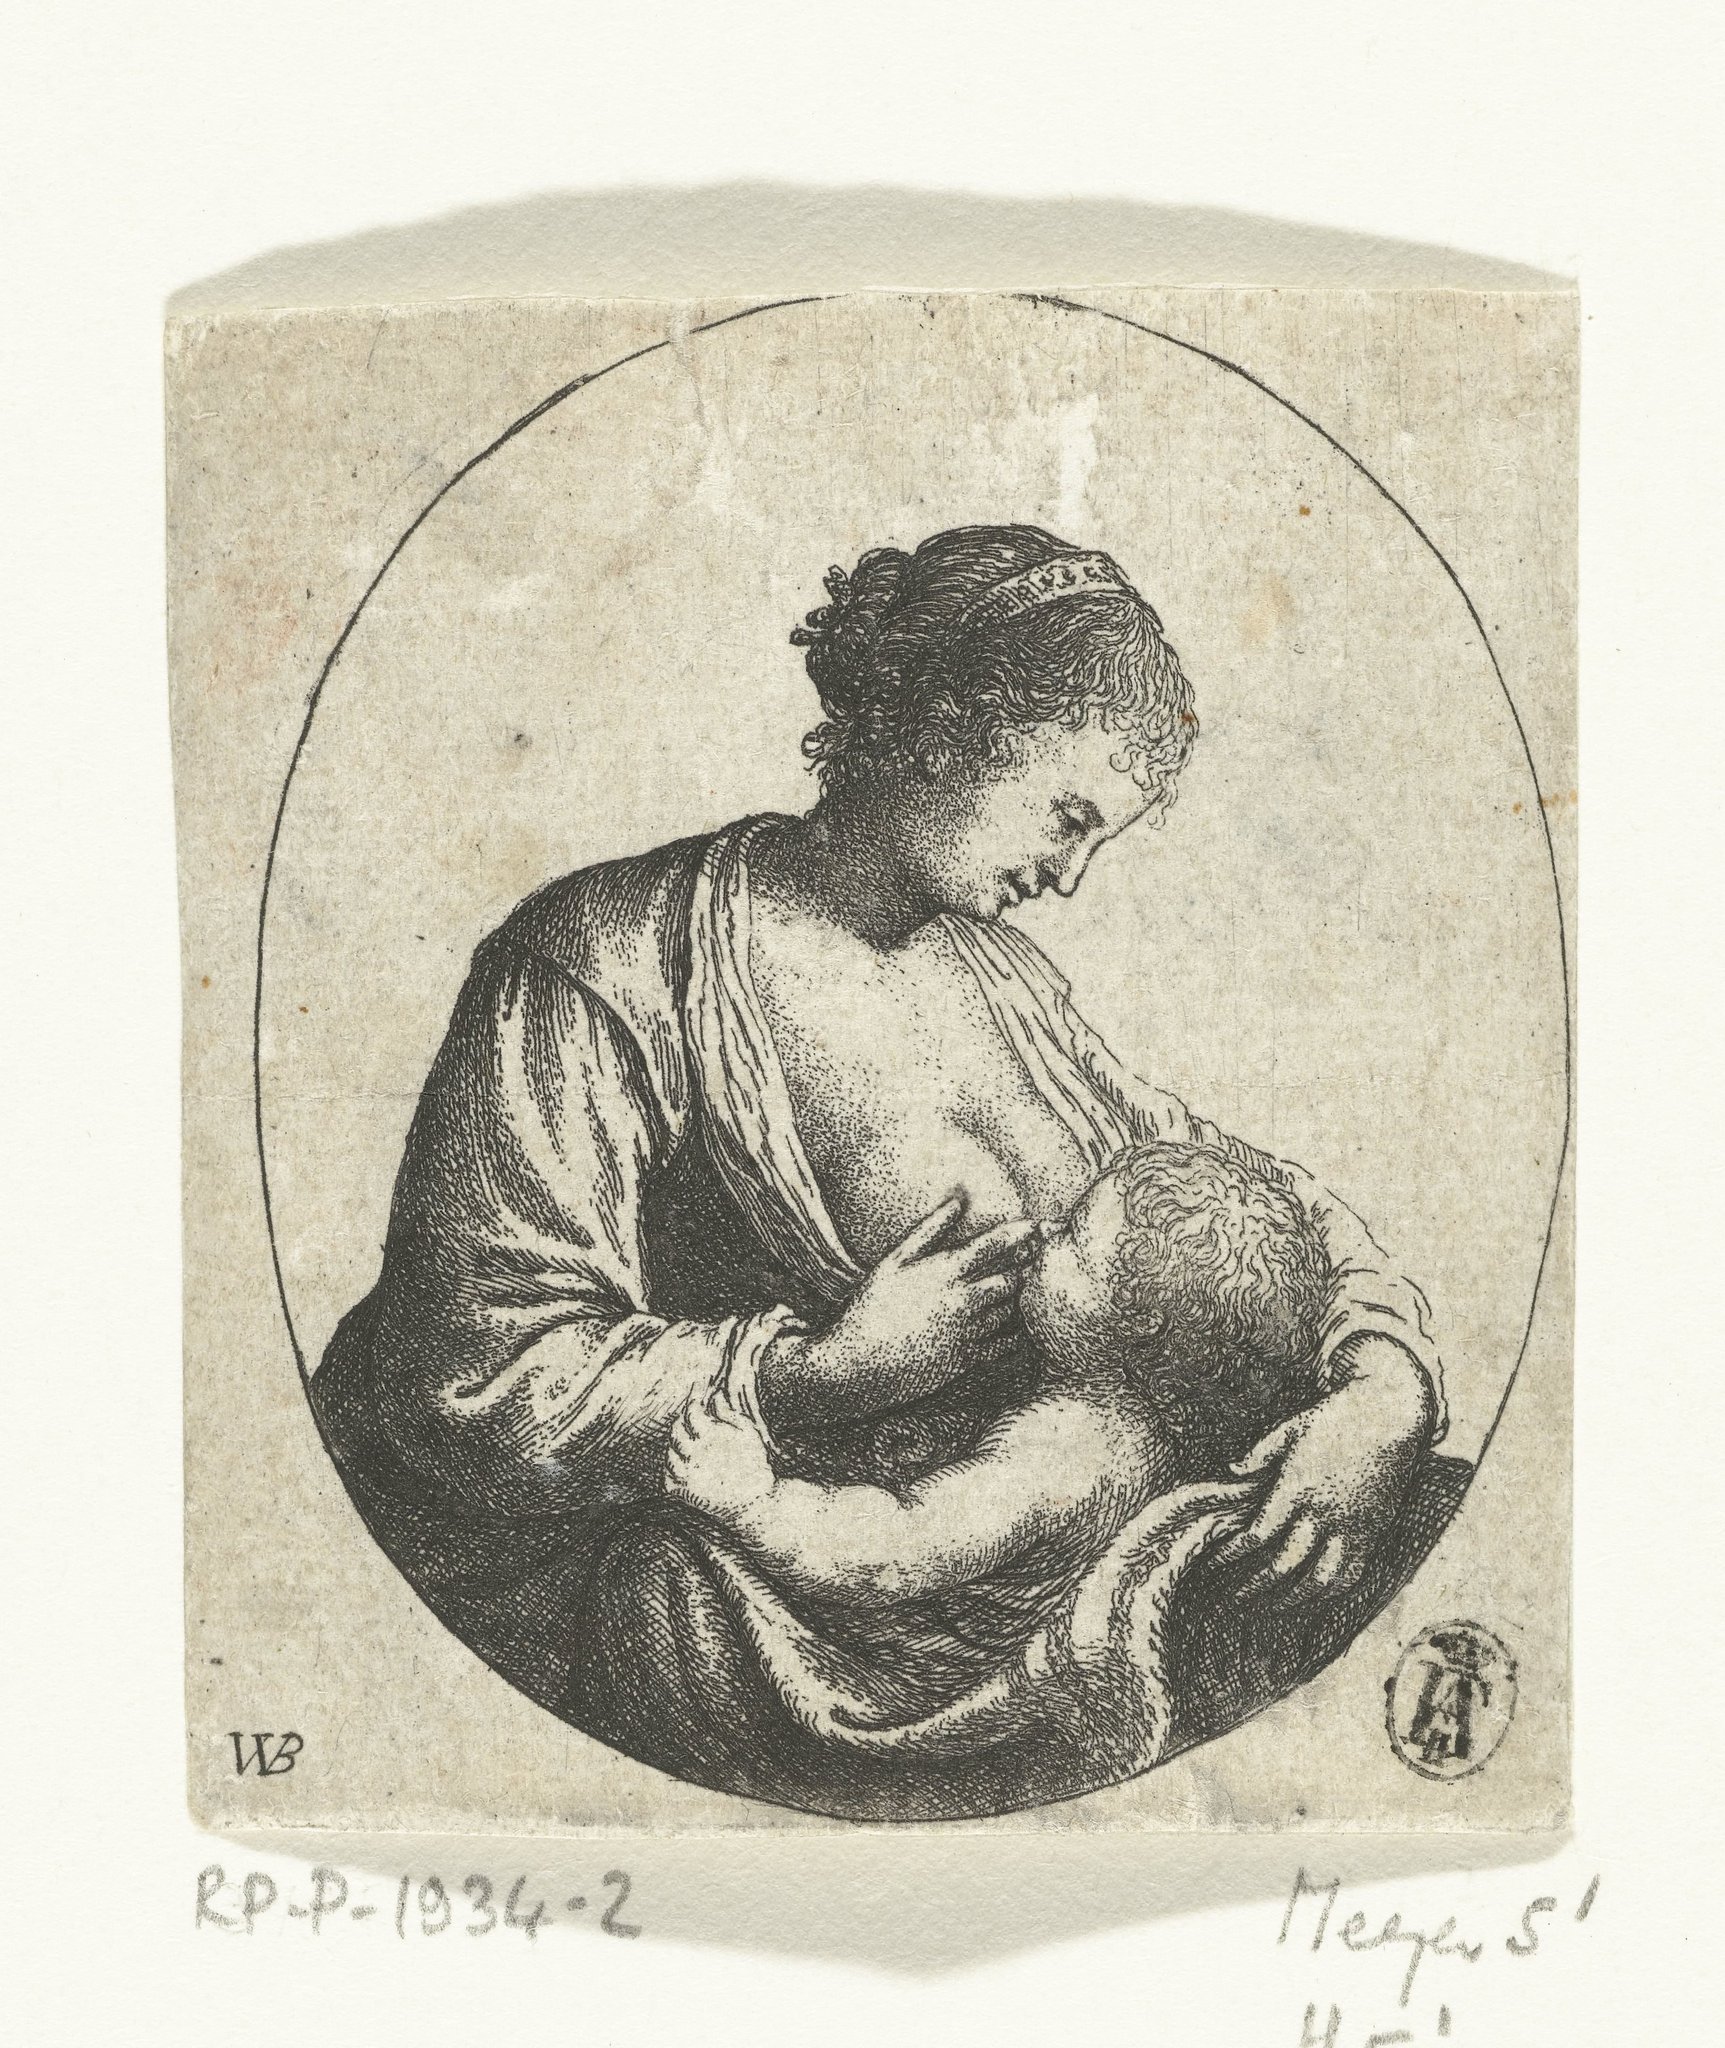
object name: print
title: Maria geeft het Christuskind de borst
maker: willem basse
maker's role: draughtsman, print maker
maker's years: 1613-1672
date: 1633-1672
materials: paper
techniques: etching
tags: madonna: mary standing (or half-length), christ-child close to her bosom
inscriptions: collector's mark, collector's mark: Lugt 2228